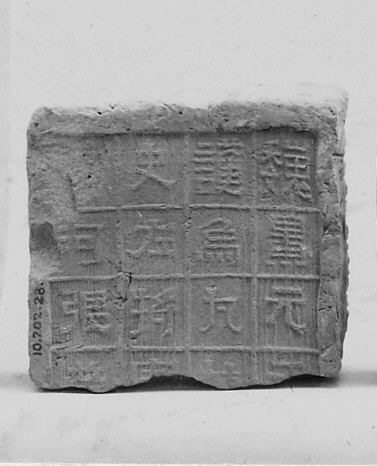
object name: tile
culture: chinese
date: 221 BCE-220 CE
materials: earthenware